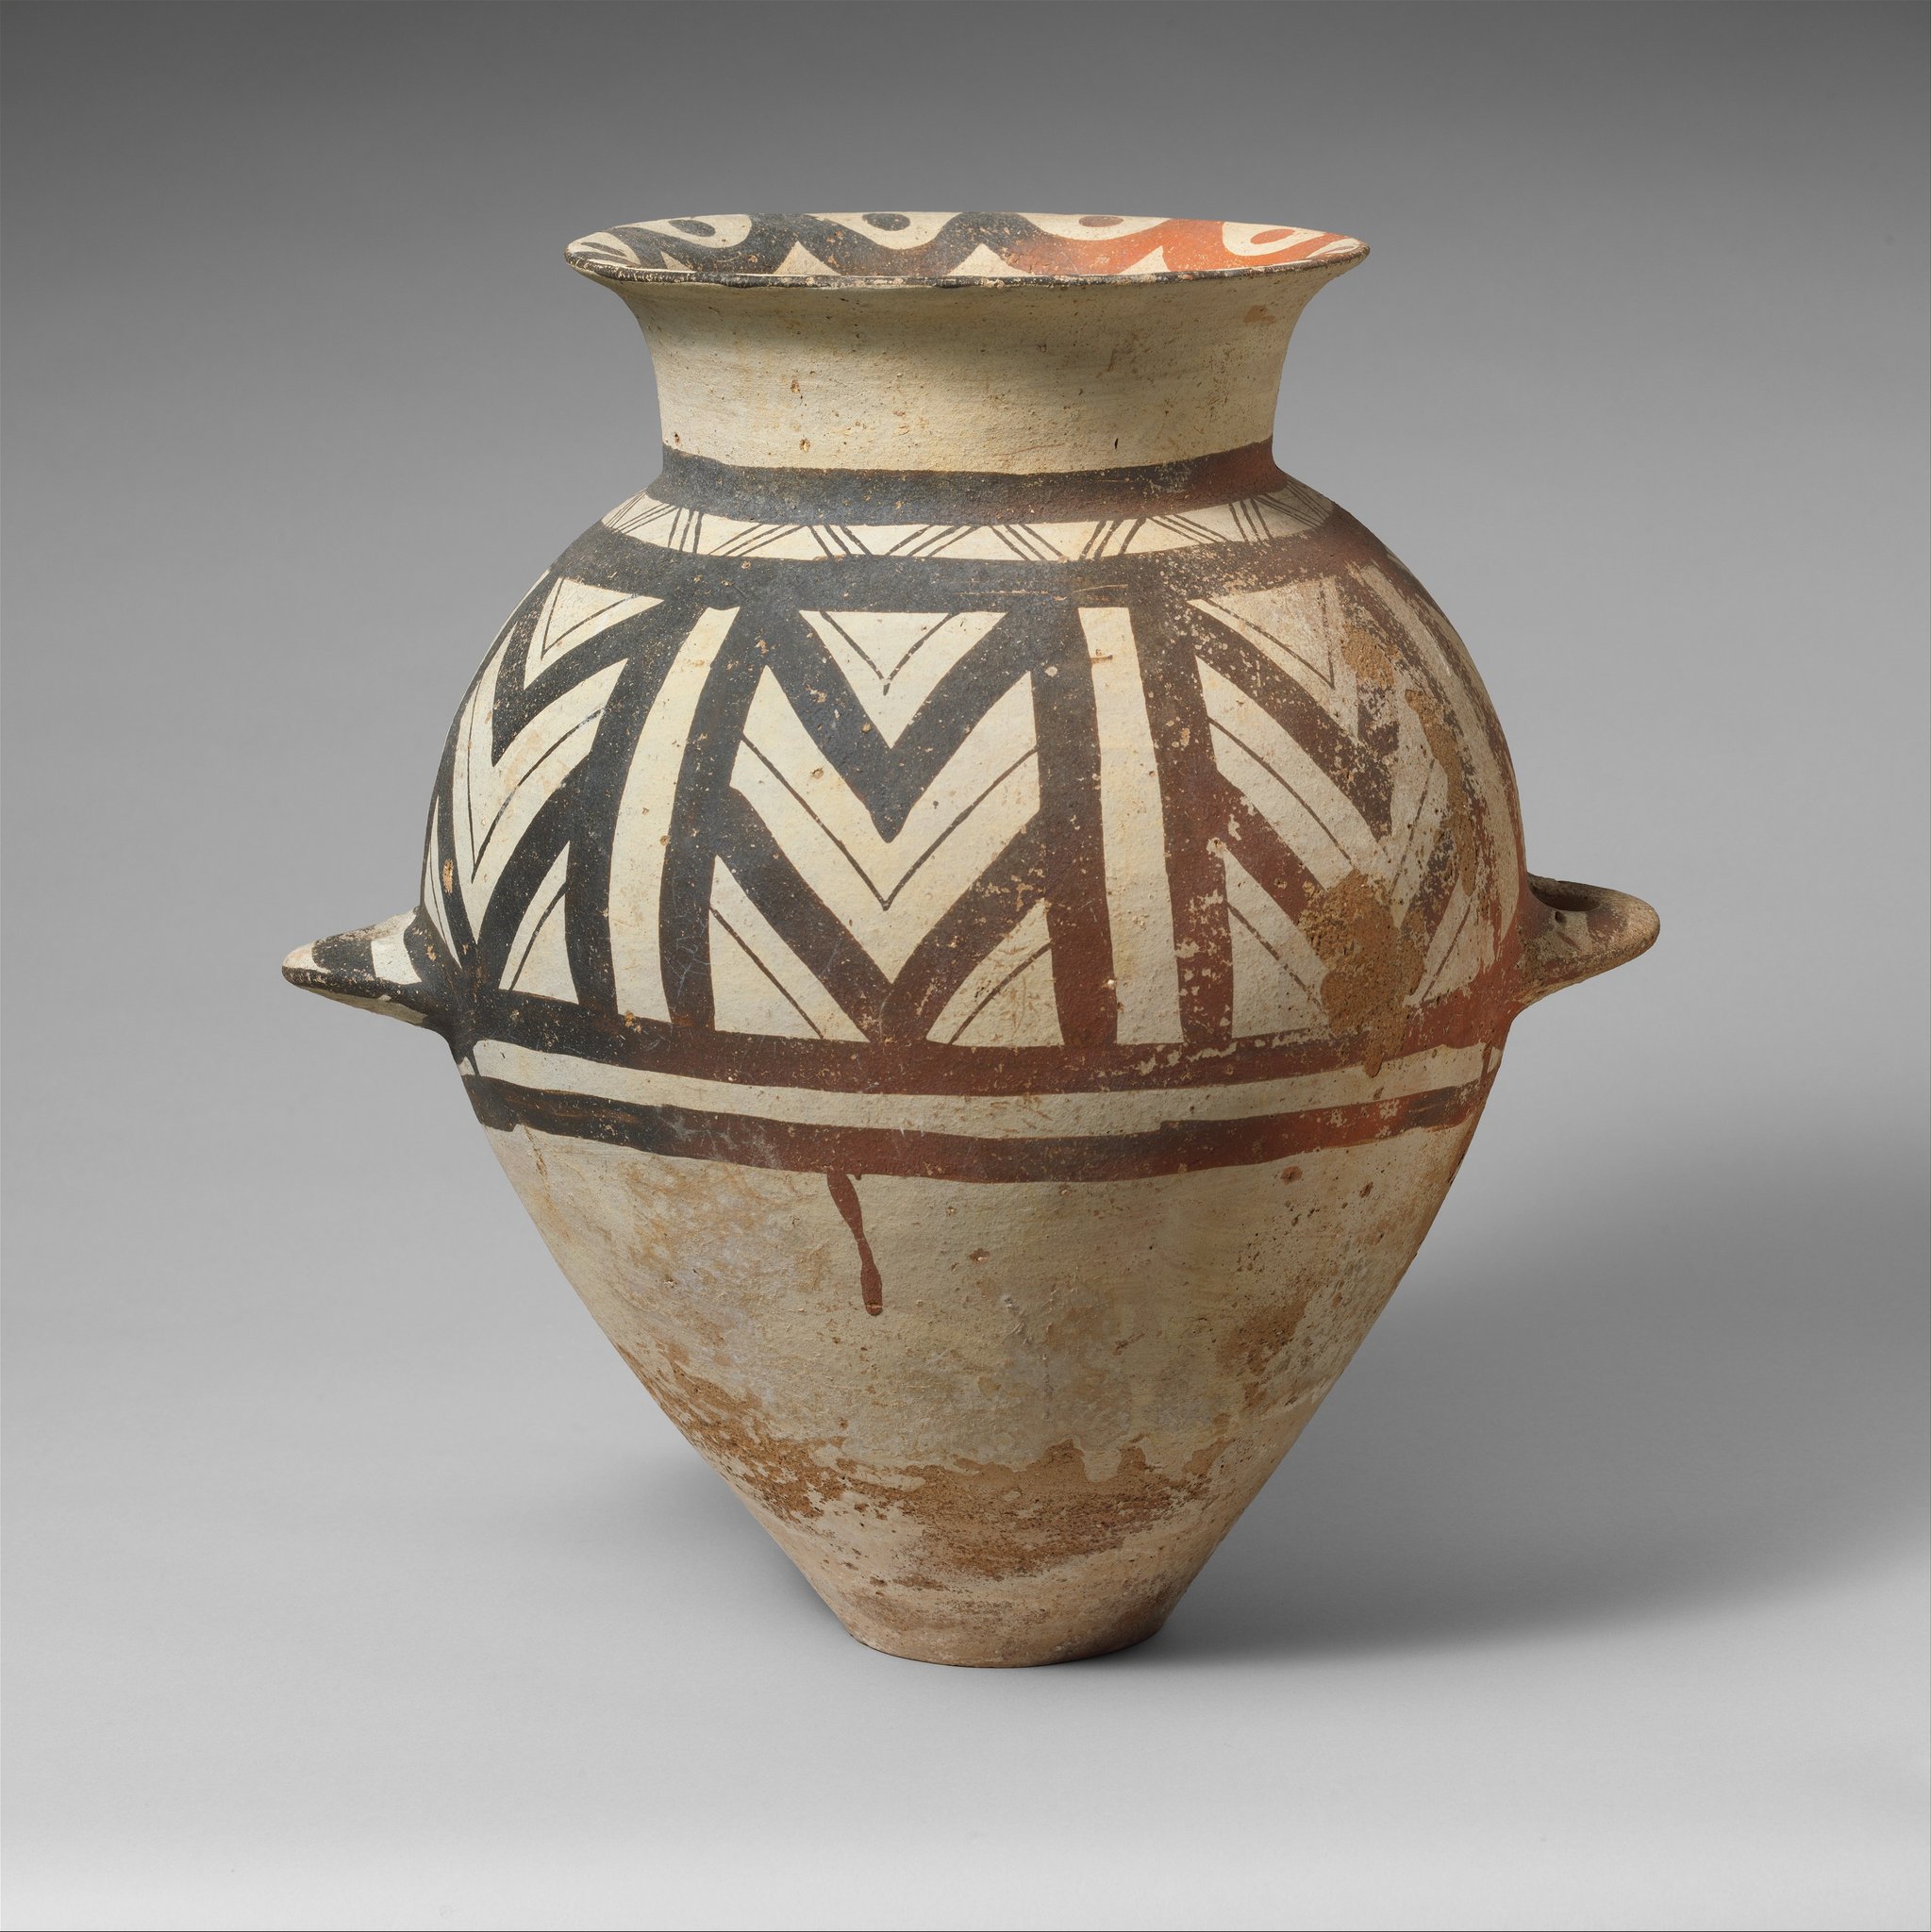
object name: jar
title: Terracotta jar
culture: cycladic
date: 2300-1900 BCE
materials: terracotta